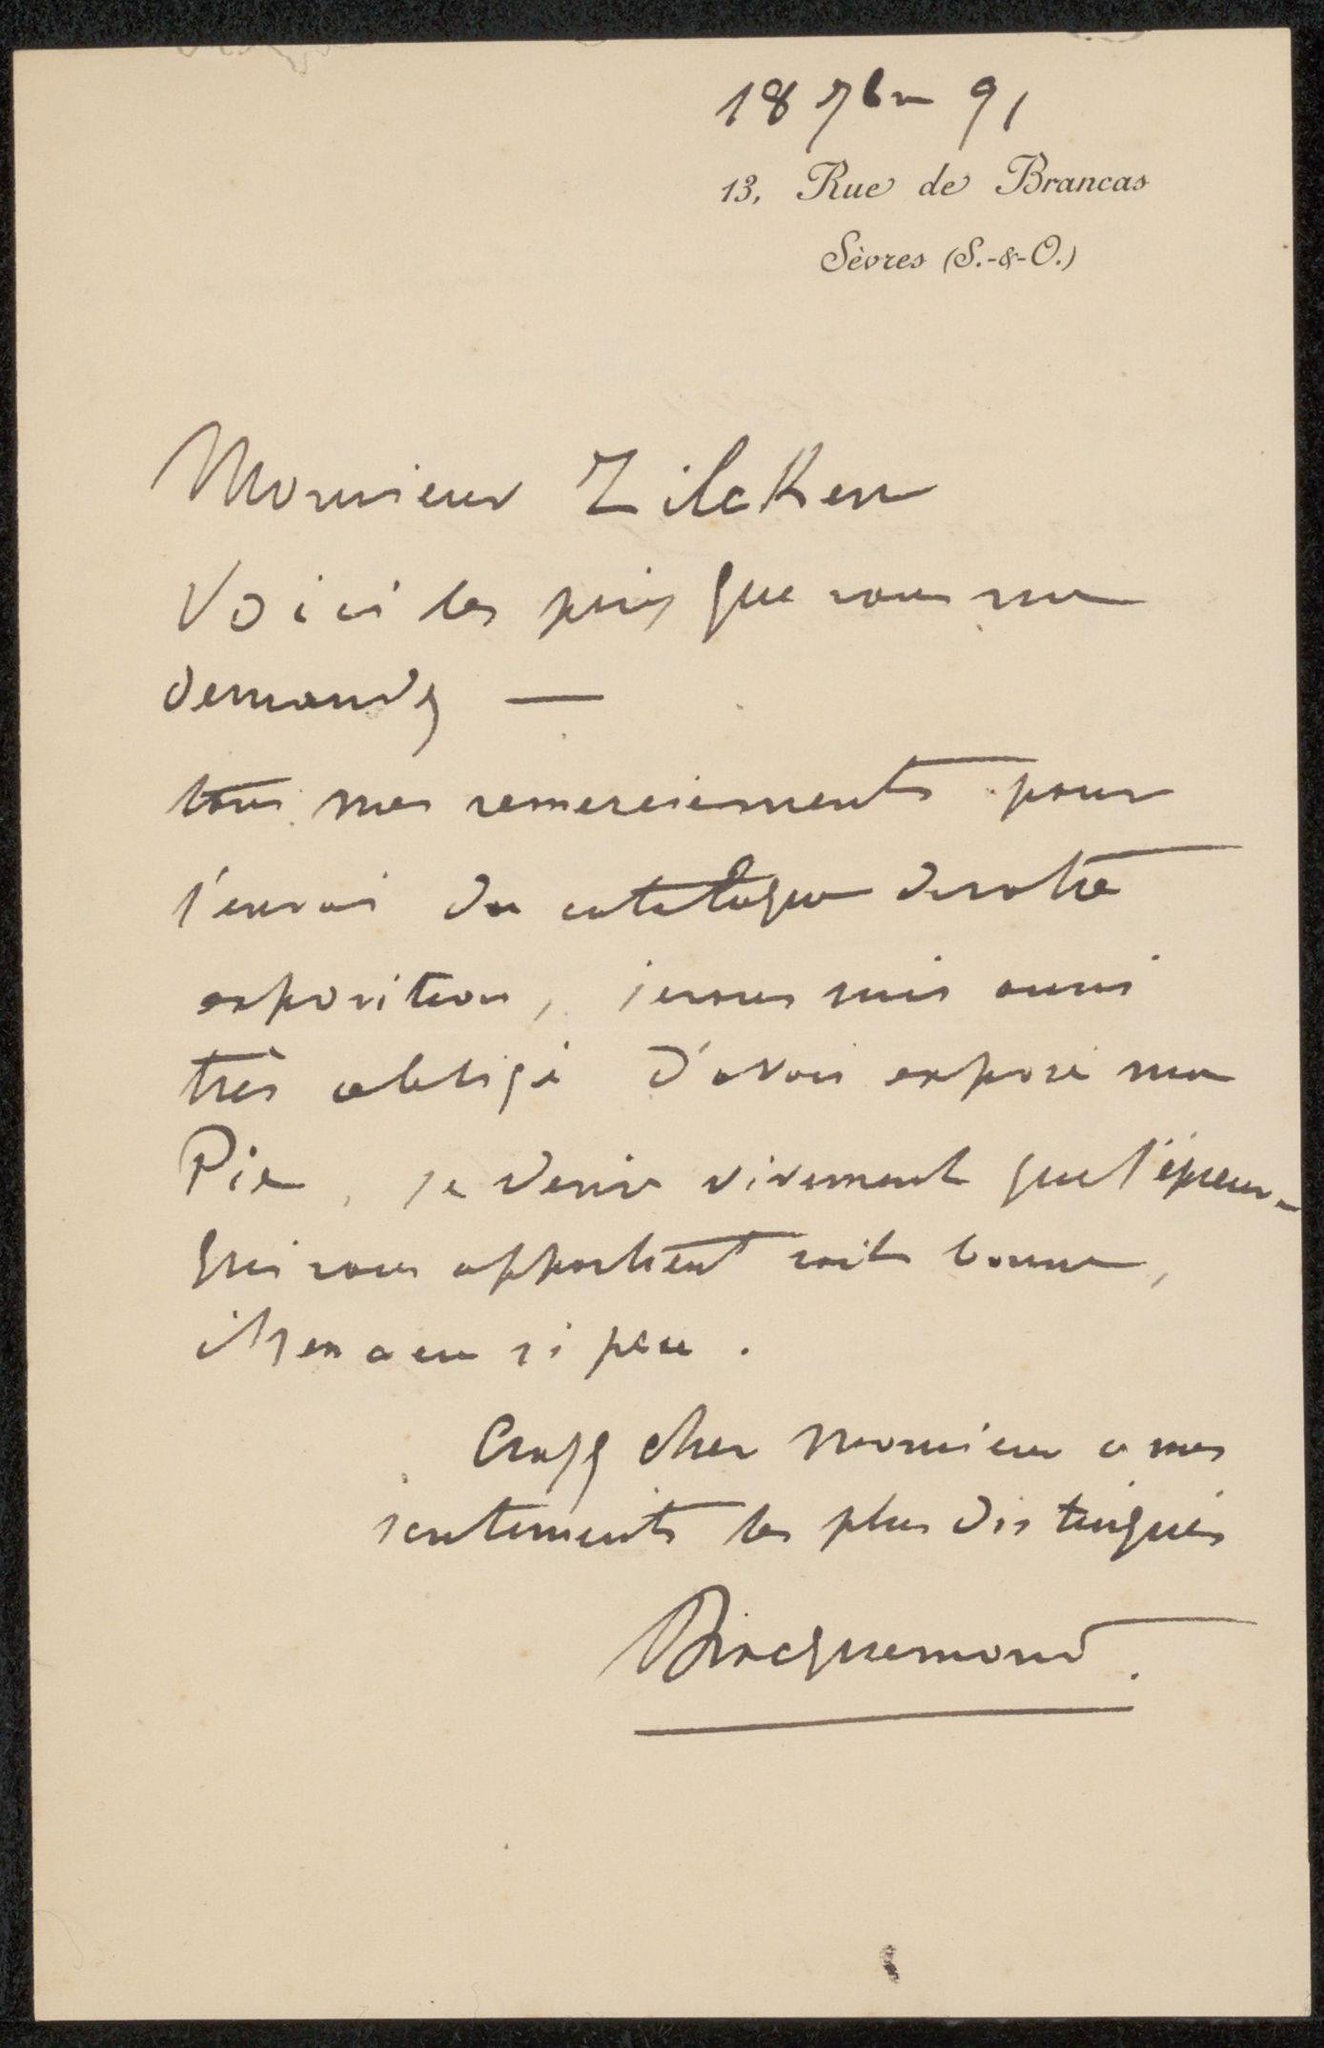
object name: letter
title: Brief aan Philip Zilcken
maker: félix bracquemond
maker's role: print maker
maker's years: 1833-1914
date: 1891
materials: ink, paper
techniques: pen, printing, writing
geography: sèvres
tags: the hague, painter, philip zilcken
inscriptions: collector's mark: ‘RPK’